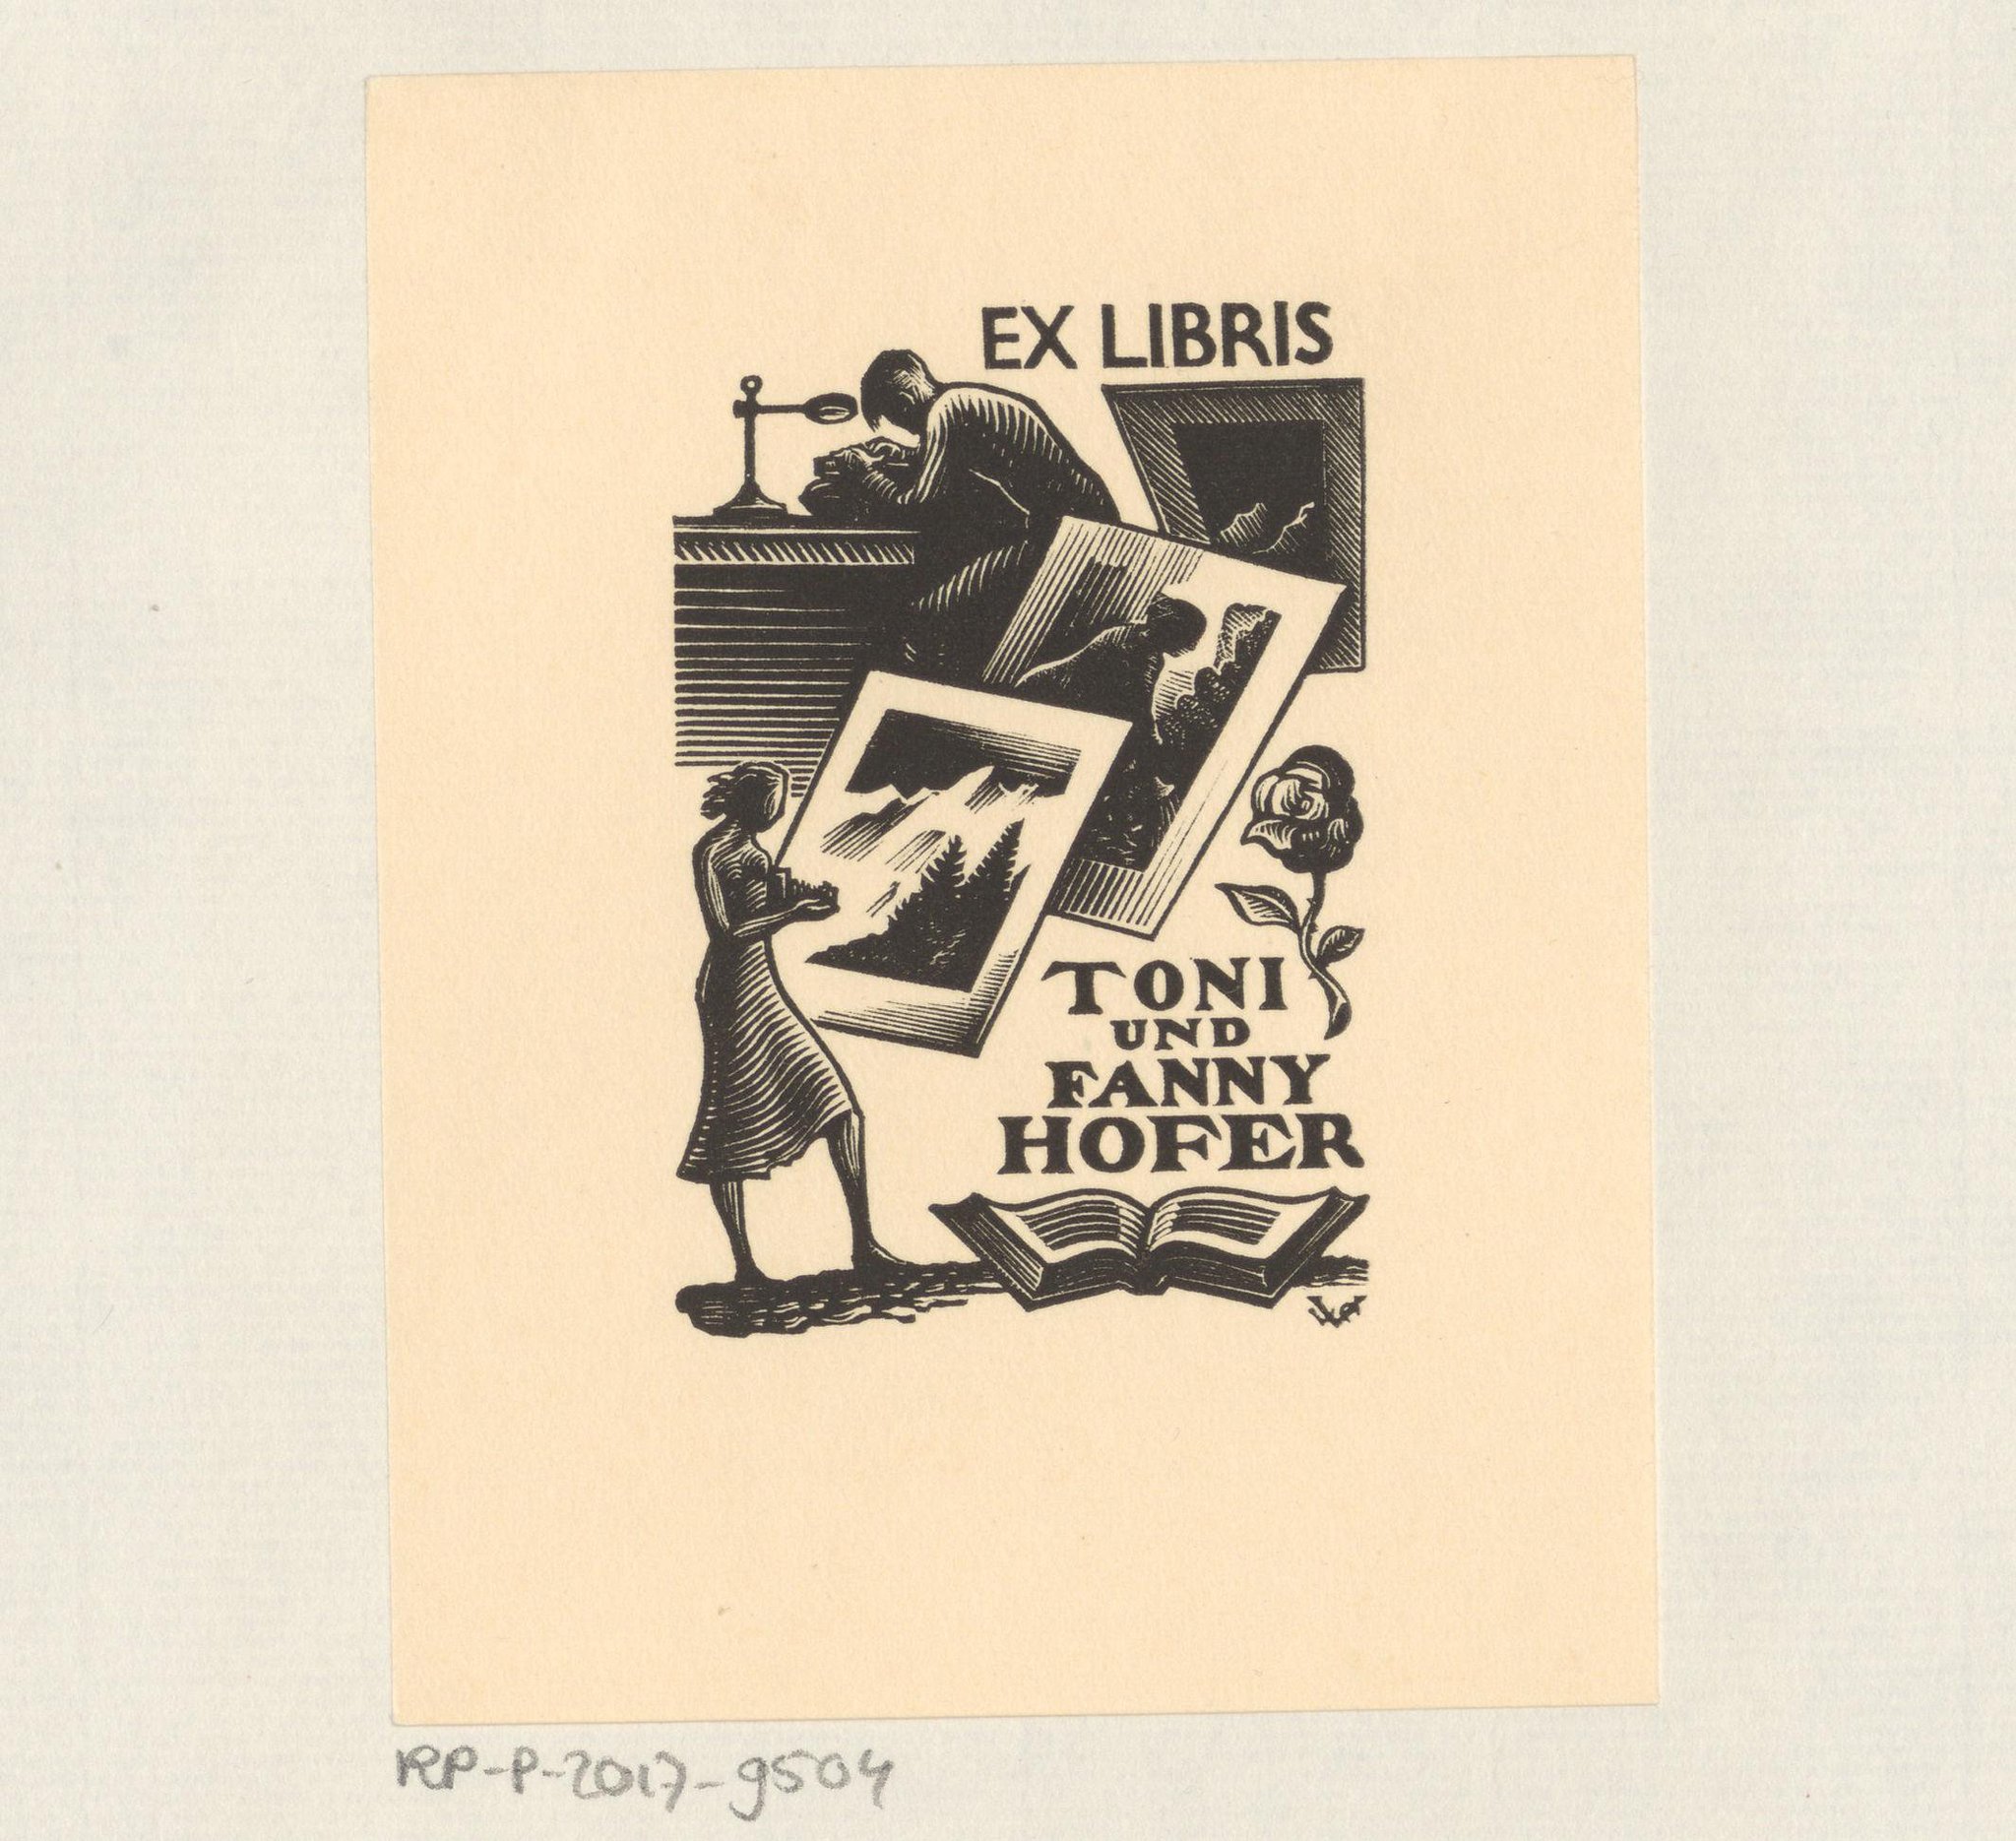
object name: bookplate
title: Ex libris van Toni en Fanny Hofer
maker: valentin le campion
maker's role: print maker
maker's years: 1861-1952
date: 1937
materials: paper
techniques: engraving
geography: france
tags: painter, toni hofer, standing figure - aa - female human figure, flowers: rose, printed matter